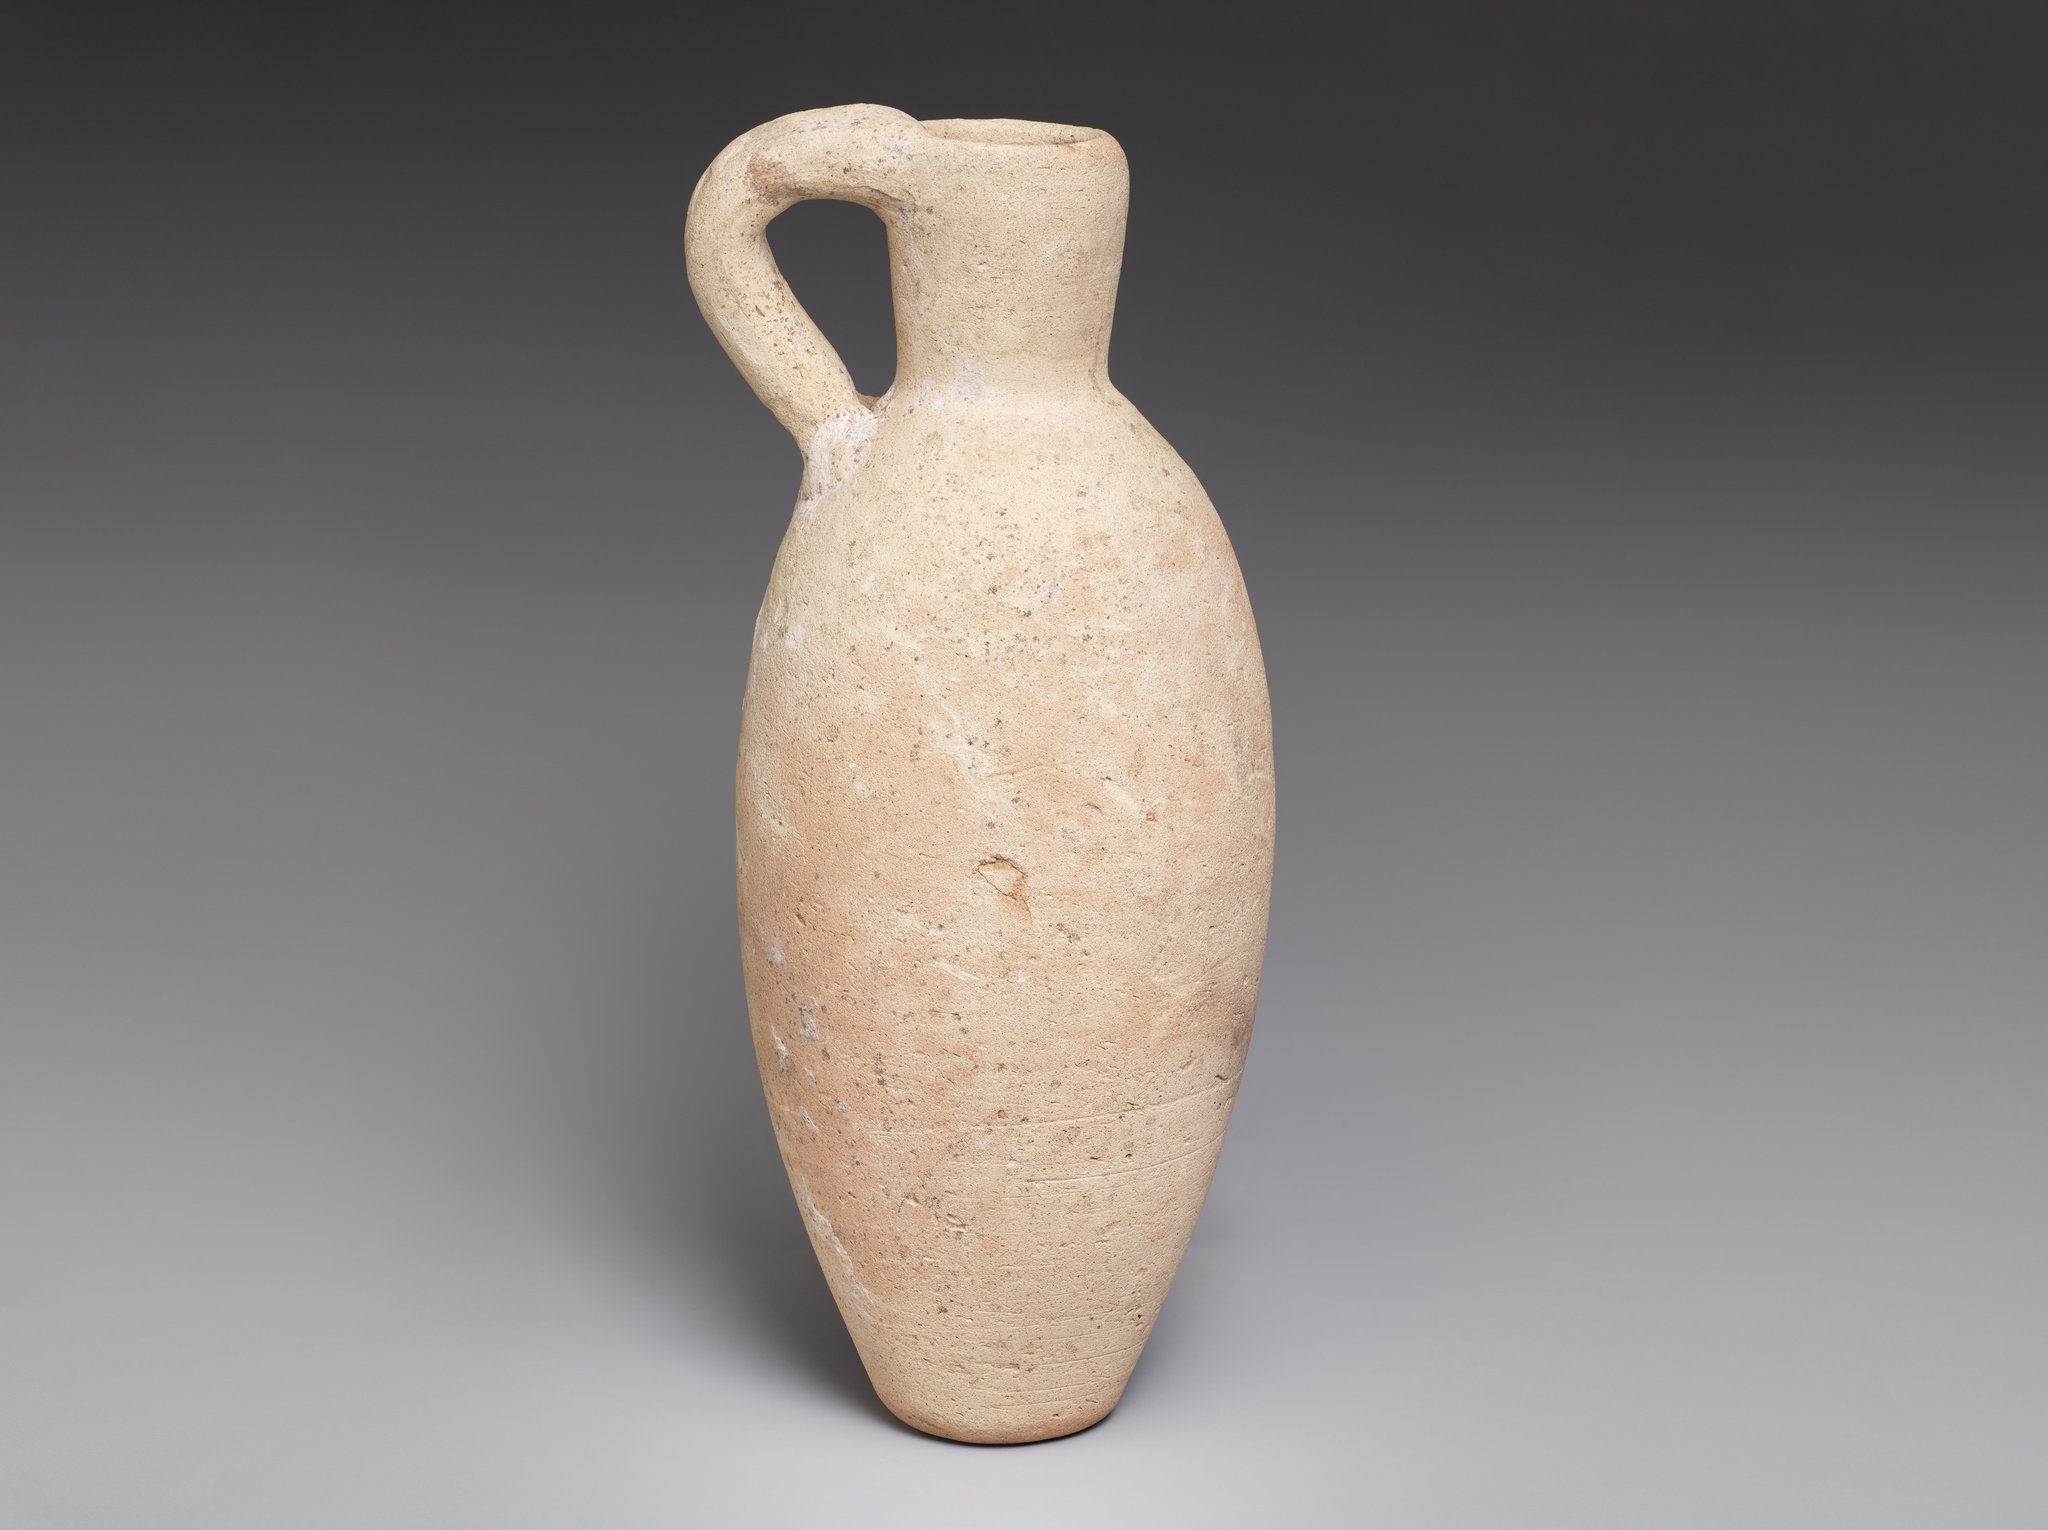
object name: jug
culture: sasanian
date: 201-700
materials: ceramic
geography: mesopotamia